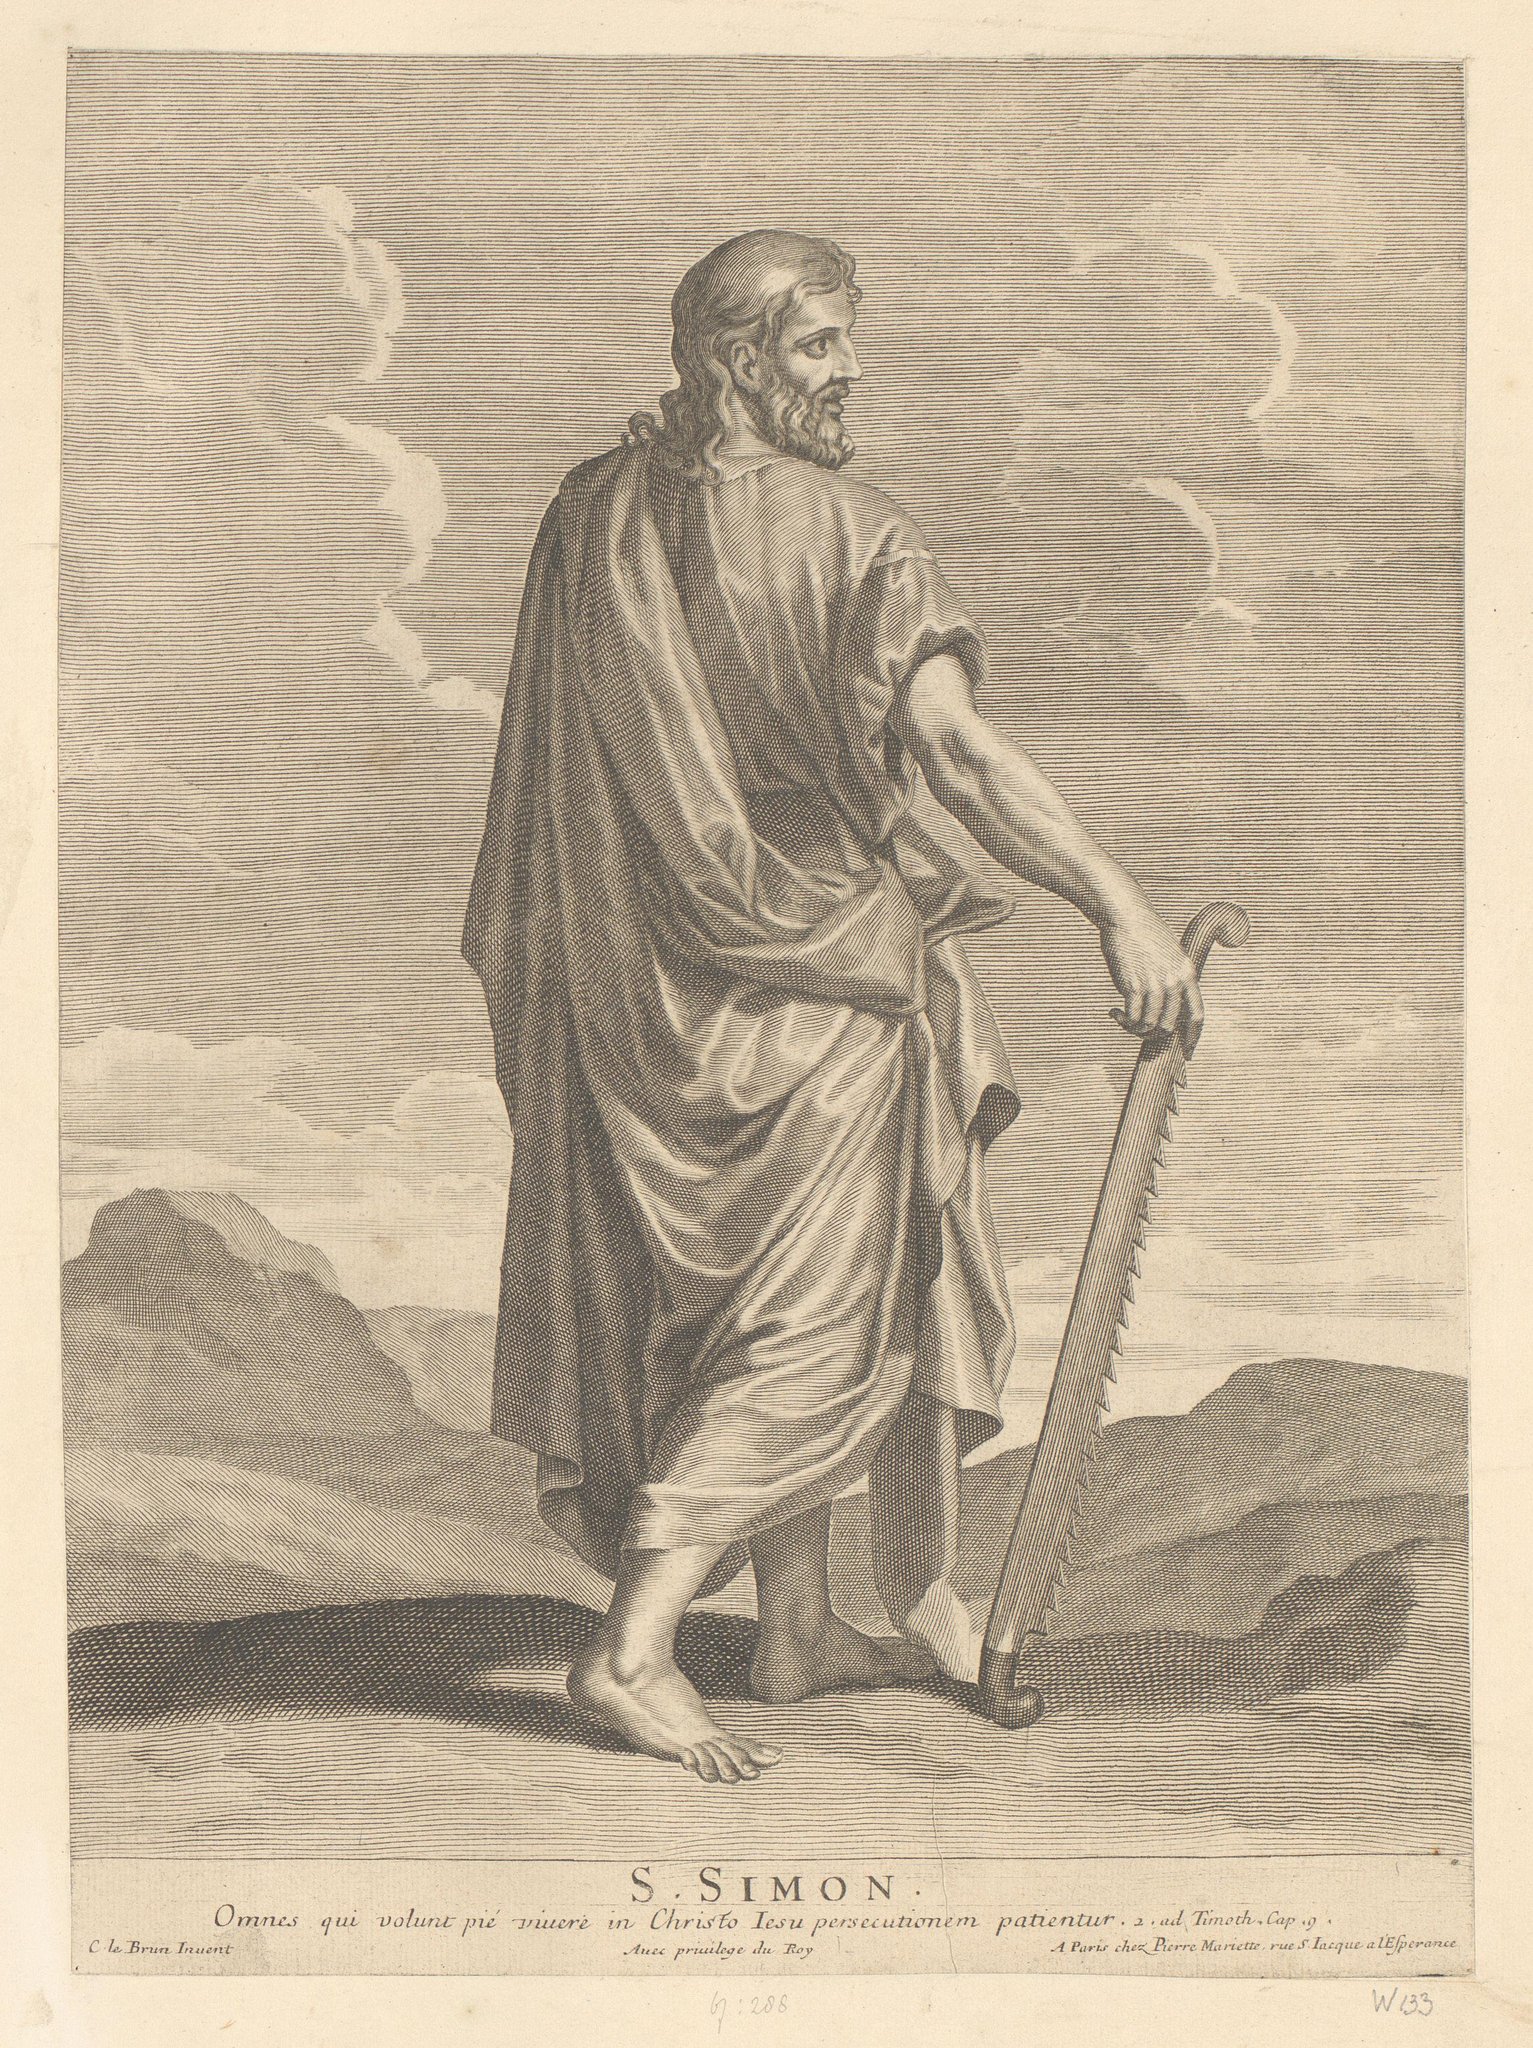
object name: print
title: Apôtres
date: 1650-1700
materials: paper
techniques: engraving, etching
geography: paris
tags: the apostle simon zelotes (or simon the canaanite); possible attributes: book, saw, scroll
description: Deze prent maakt deel uit van een album.